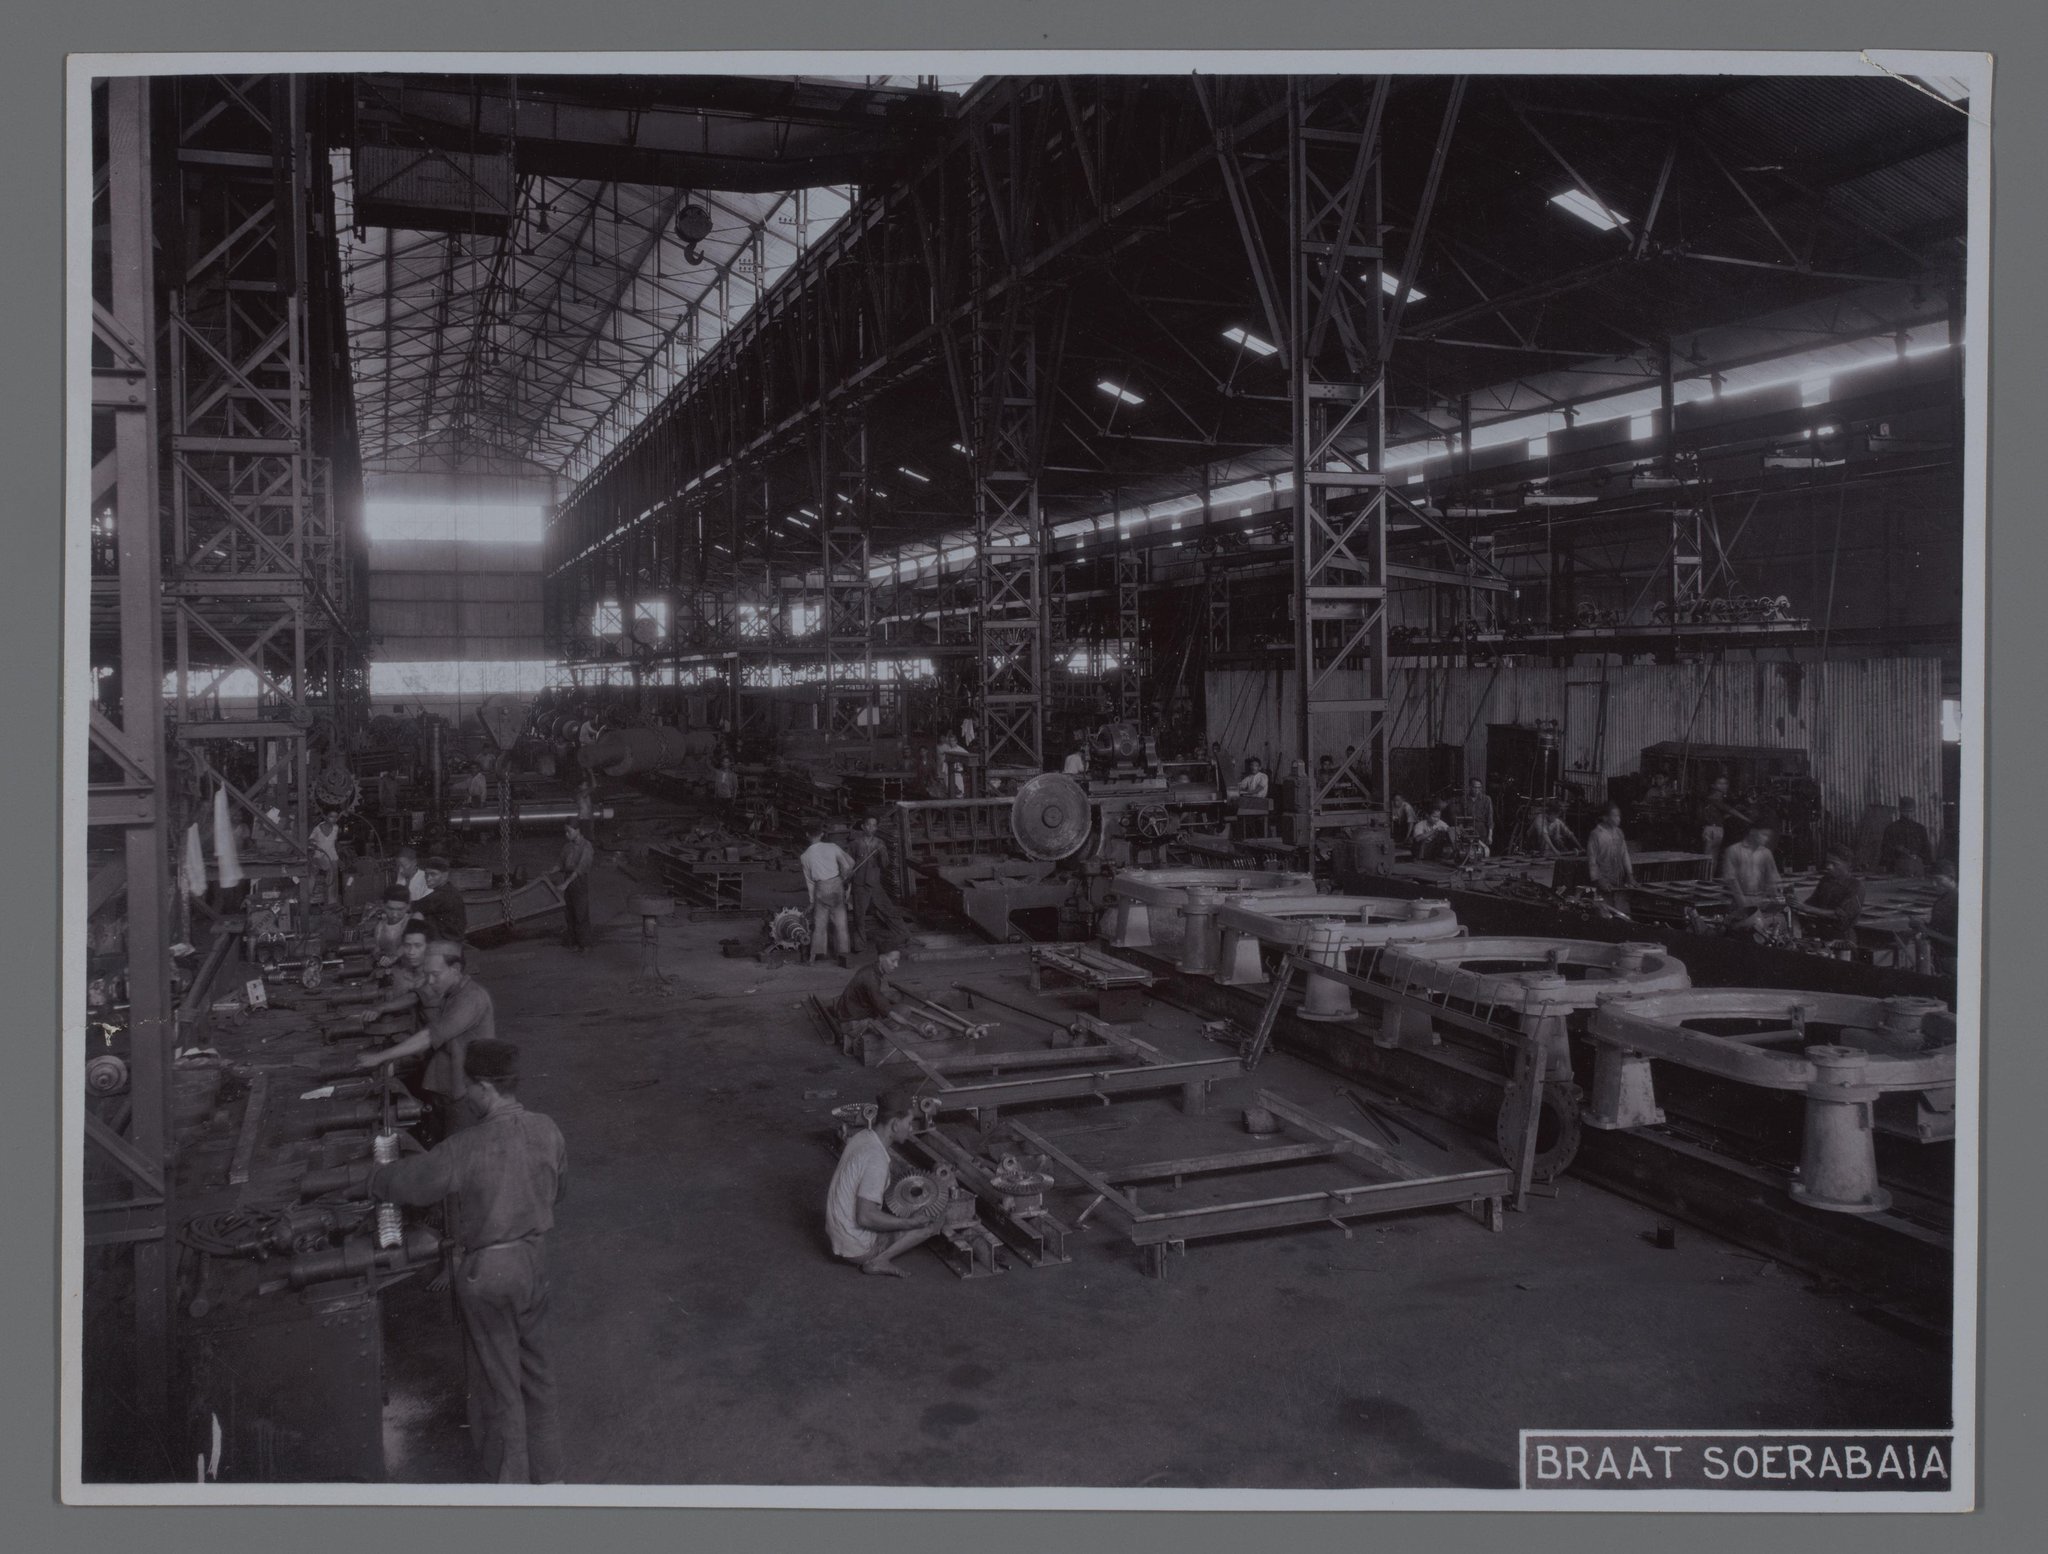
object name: photograph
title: Kleine bankwerkerij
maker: Anonymous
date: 1925-1935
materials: photographic support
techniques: photography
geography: surabaya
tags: colonial system, machines; parts of machines; tools and appliances, factory-interior, machine shop (+ men (labourers)), java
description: Fabriekshal met de kleine bankwerkerij te Soerabaja, ca. 1930. Onderdeel van de multomap met foto's van machines van de N.V. Machinefabriek Braat te Soerabaja, Soekaboemi en Jogyakarta, uit de periode 1908-1942.